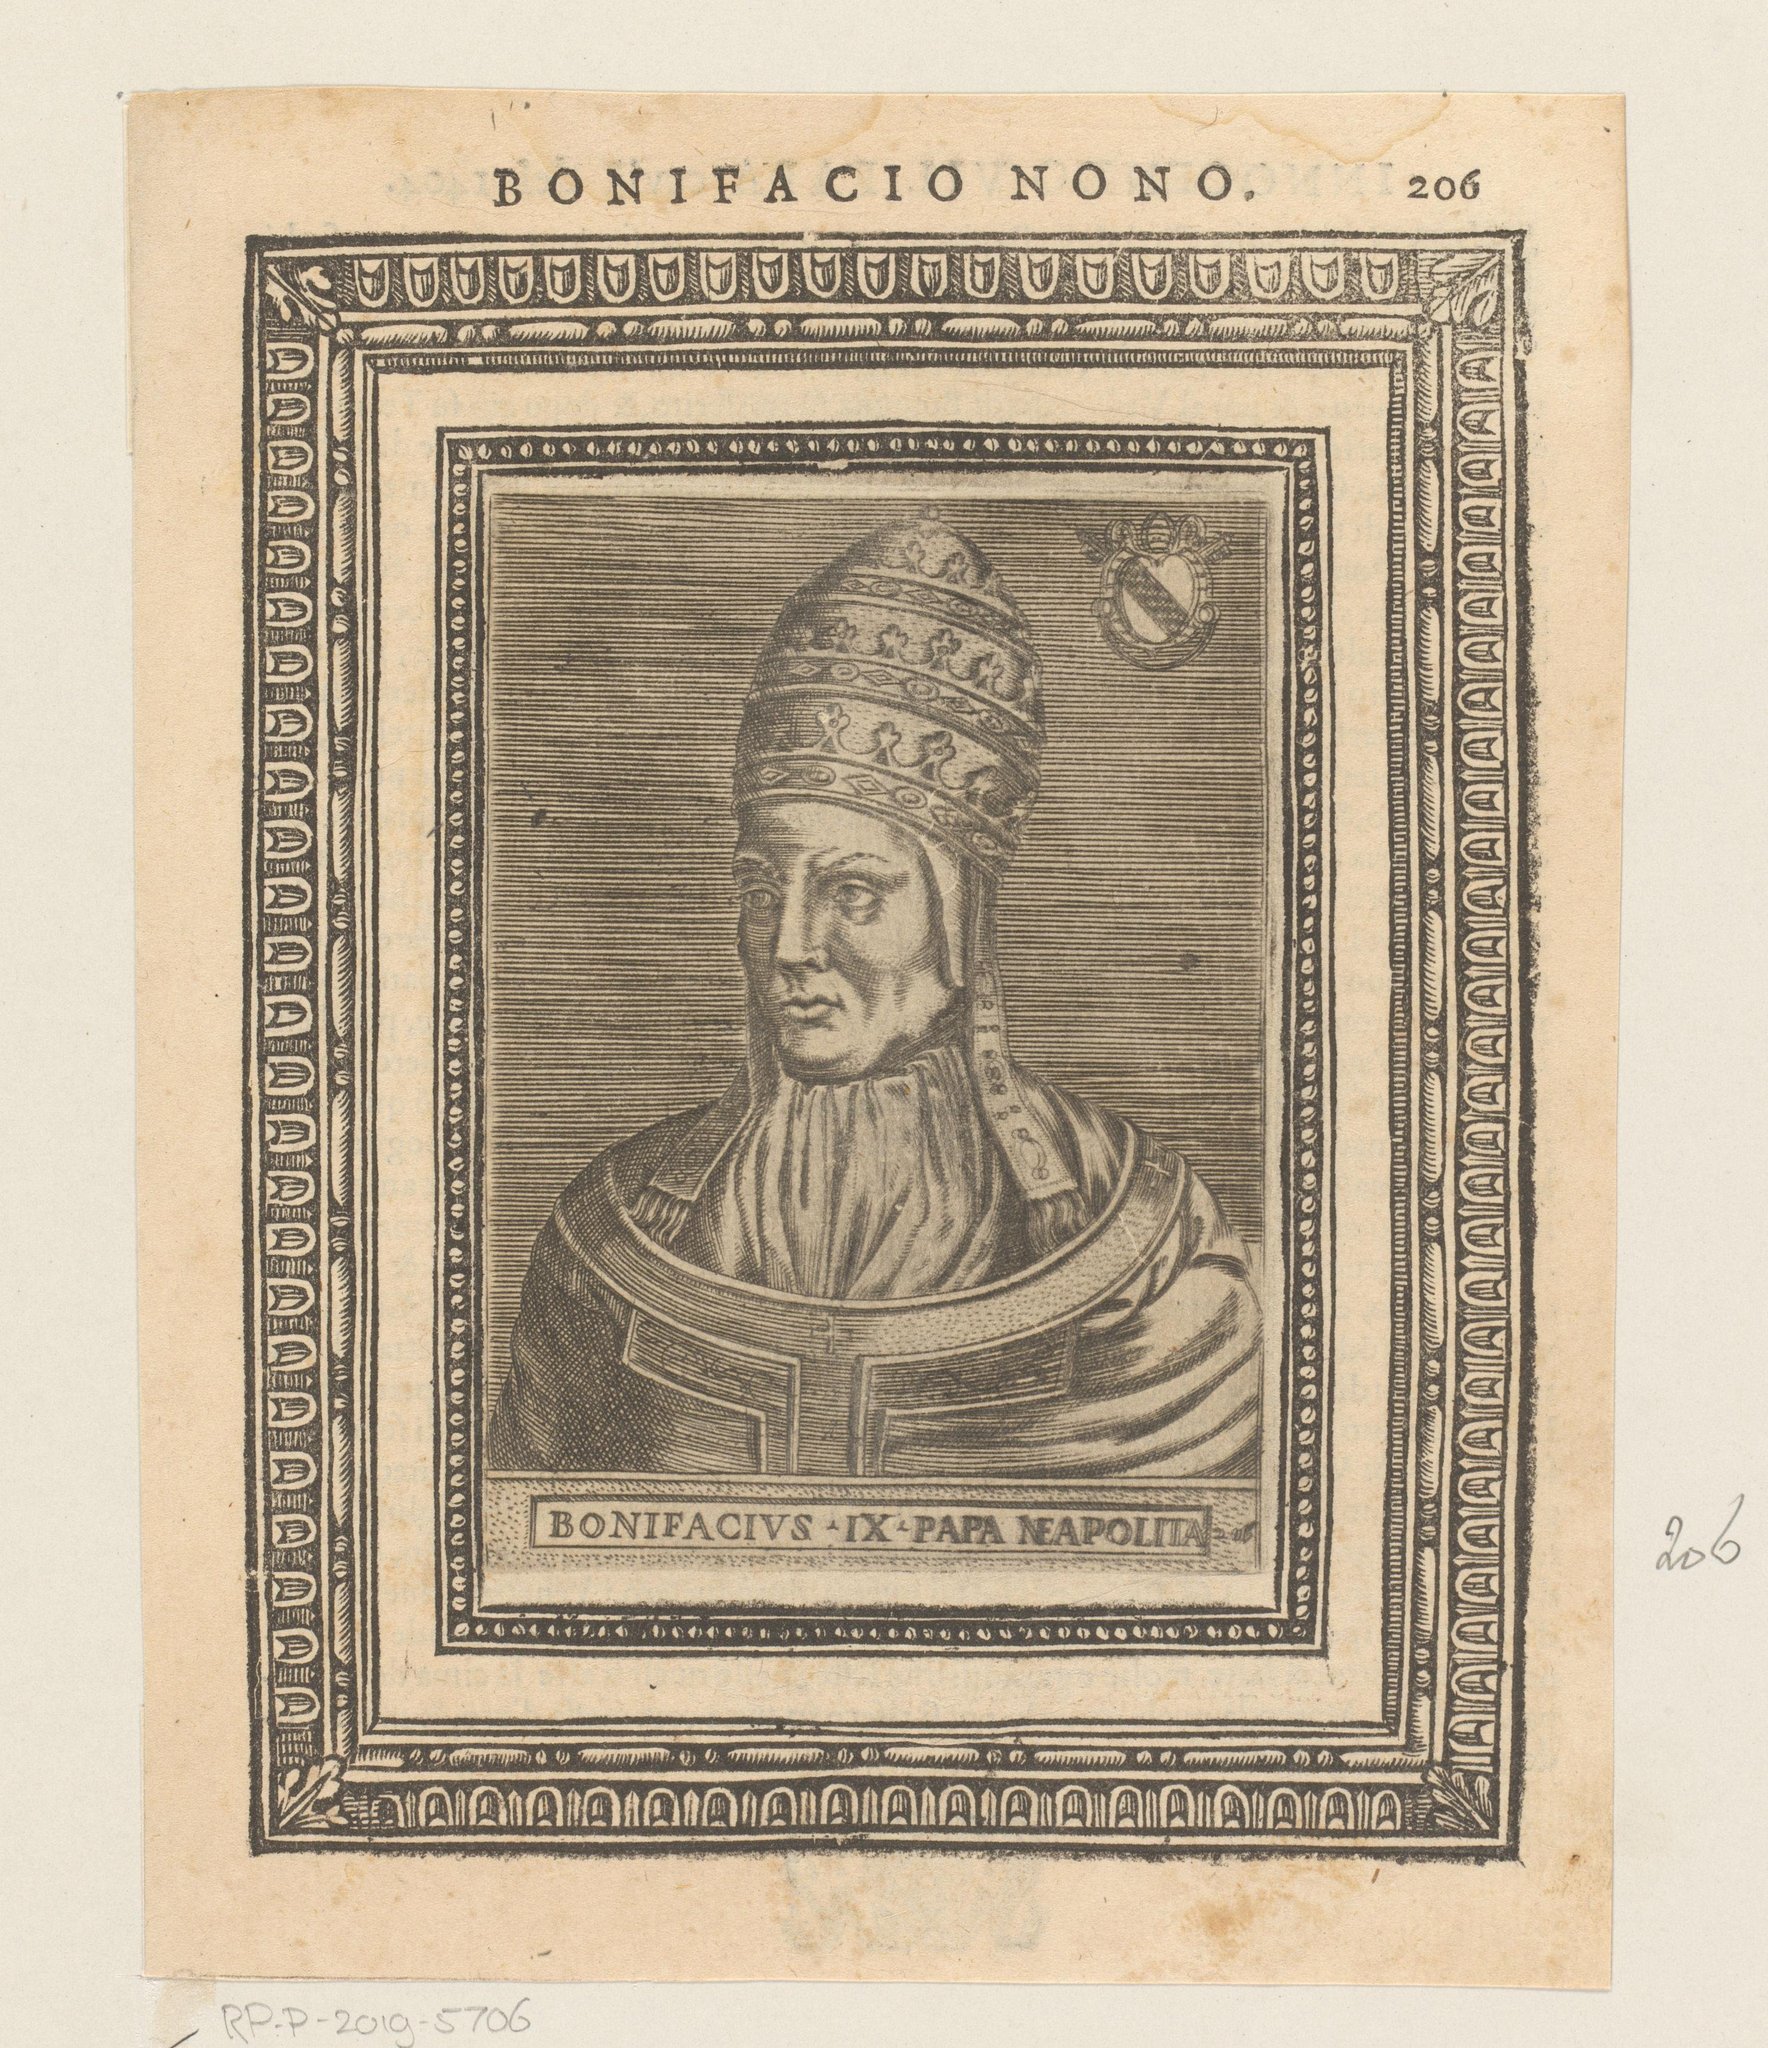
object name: print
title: Portret van paus Bonifatius IX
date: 1587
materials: paper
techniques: engraving, letterpress printing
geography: rome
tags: naples, historical persons, pope, armorial bearing, heraldry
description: Prent uit: Ciccarelli, Antonio. Le vite de Pontefici di Antonio Ciccarelli (...). Rome: Domenico Basa, 1587. Prent voor het eerst verschenen in: Cavalieri, Giovanni Battista de'. Pontificum romanorum effigies (...). Rome: Domenico Basa en Francesco Zanetti, 1580. Prent ook gebruikt in latere publicaties.